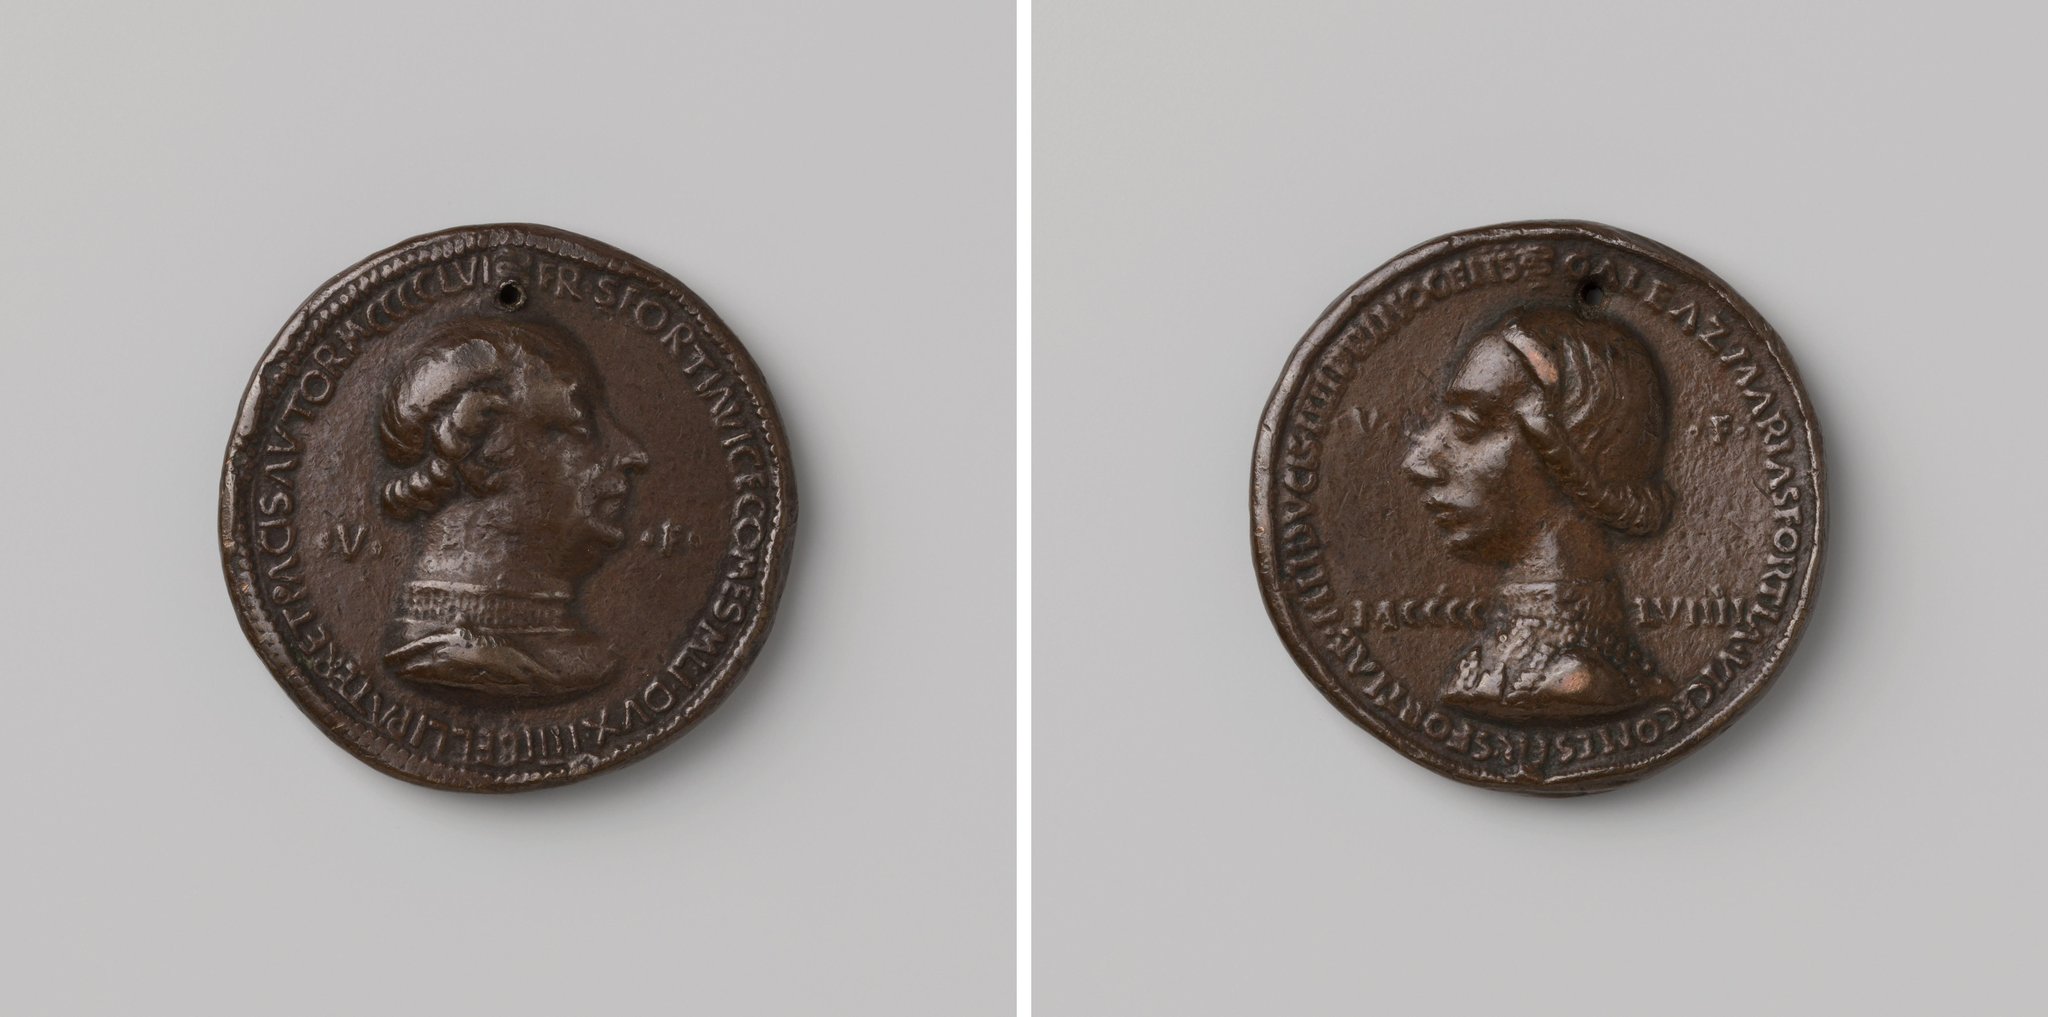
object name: history medal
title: Francesco Sforza en zijn zoon Galeazzo-Maria Sforza, hertogen van Milaan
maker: gianfrancesco enzola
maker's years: 1456-1513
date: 1459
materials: bronze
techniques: casting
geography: italy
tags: politician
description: Bronzen penning met gat erin. Voorzijde: borststuk man tussen opschrift, binnen omschrift. Keerzijde: borststuk man tussen opschrift, binnen omschrift